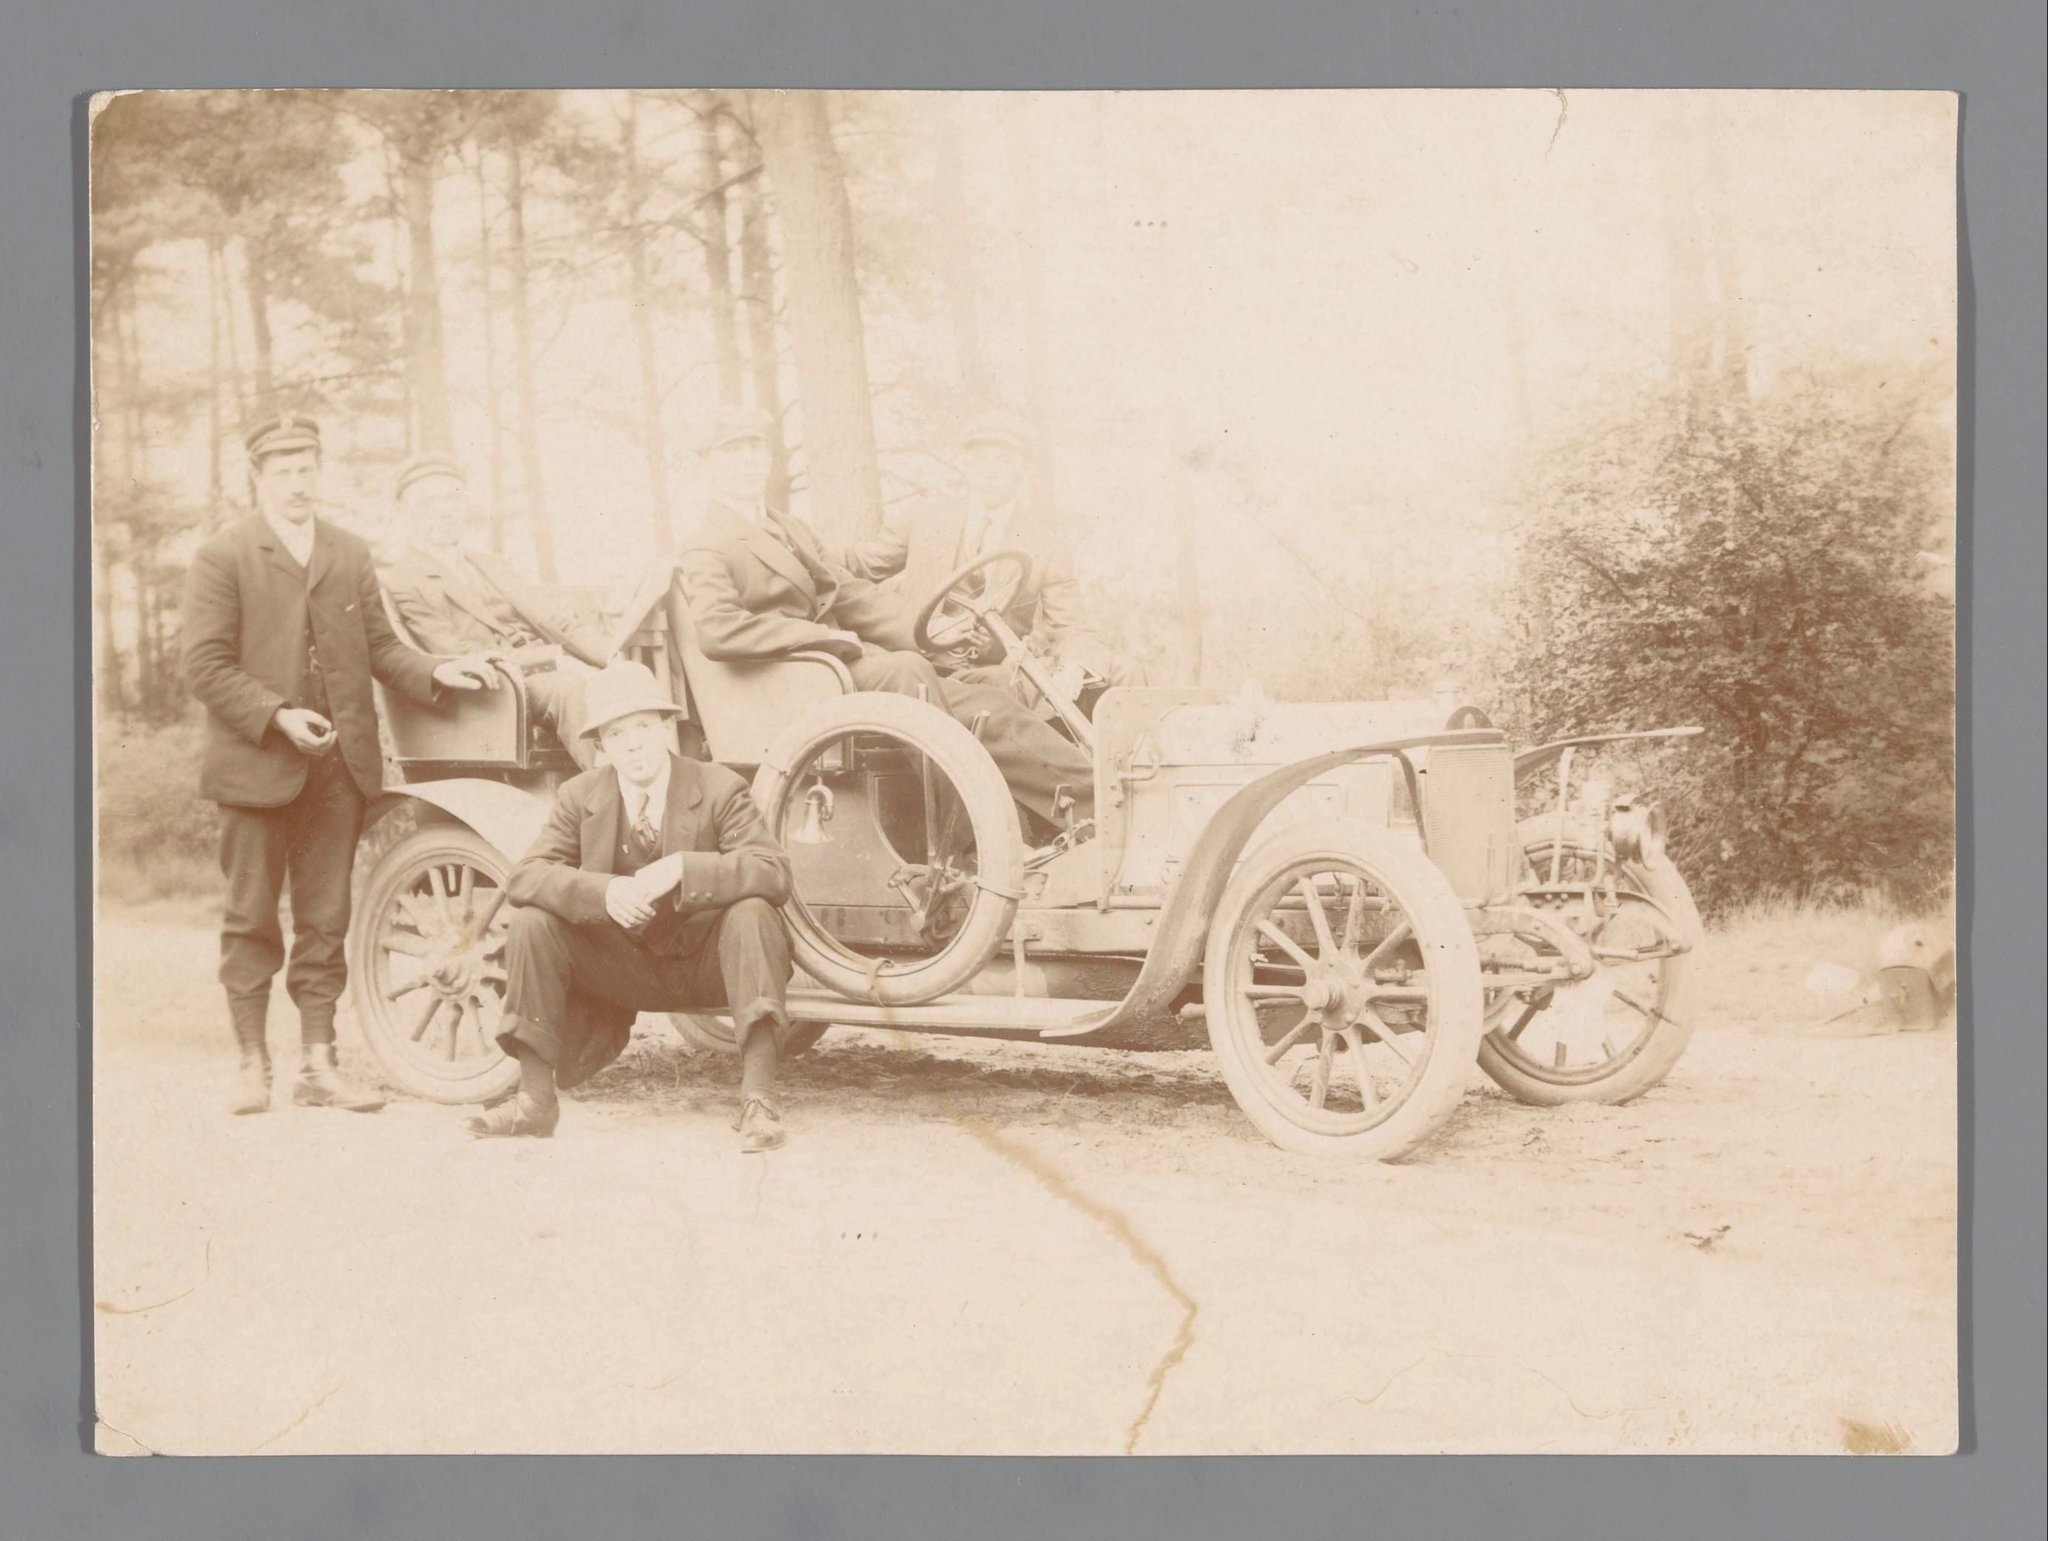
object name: photograph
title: Vijf onbekende mannen rond een auto in een bos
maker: Anonymous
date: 1909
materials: photographic support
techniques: gelatin silver print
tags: adult man, automobile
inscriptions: inscription: ‘1909’